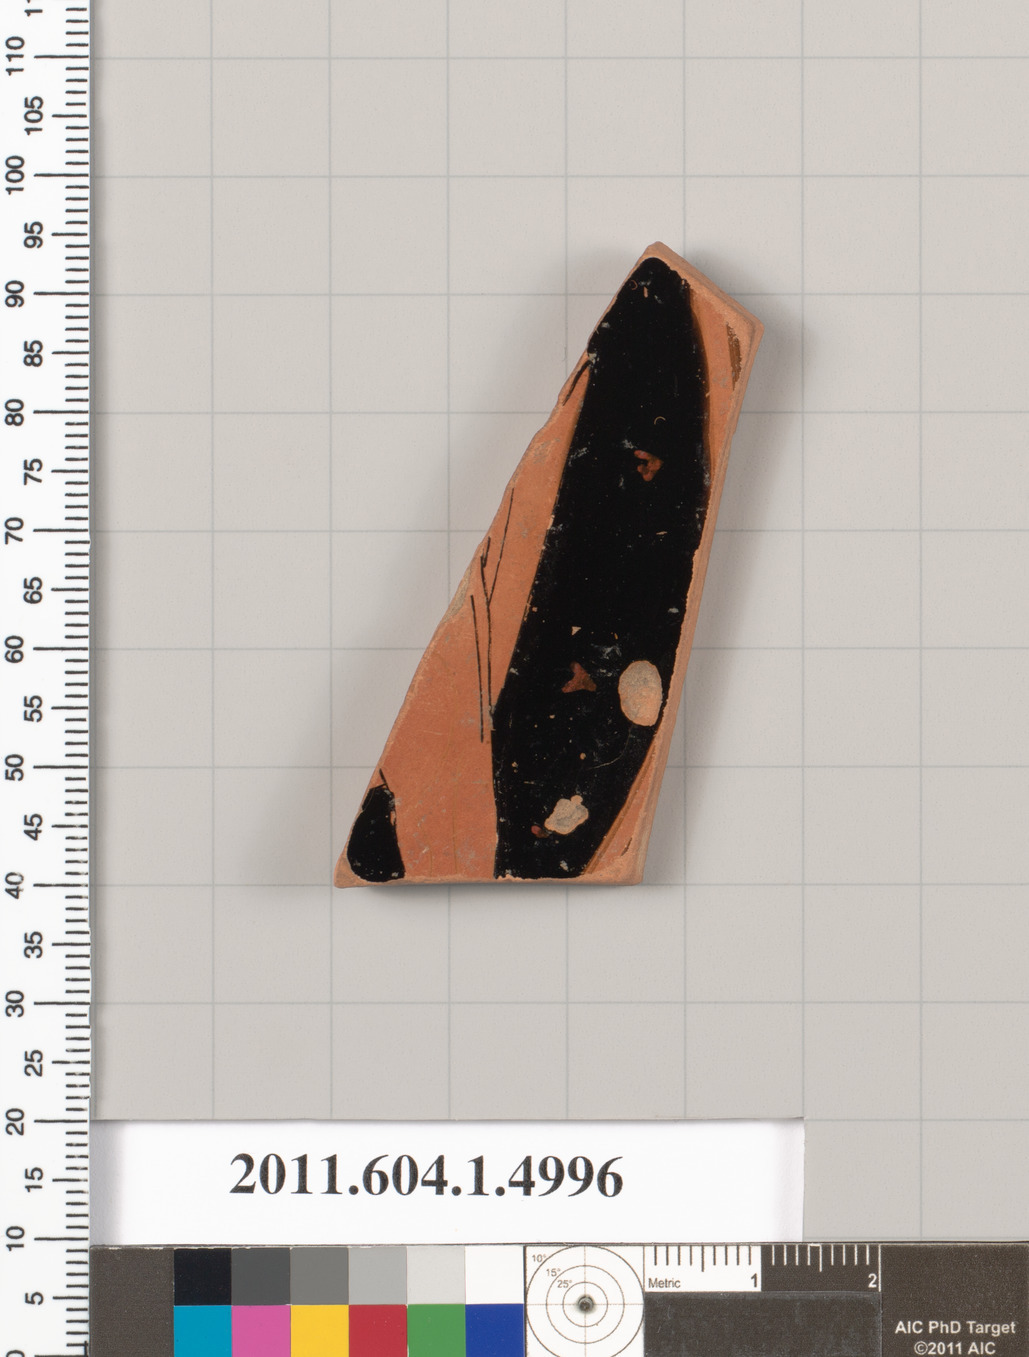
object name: kylix fragment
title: Terracotta fragment of a kylix (drinking cup)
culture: greek, attic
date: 500-480 BCE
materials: terracotta